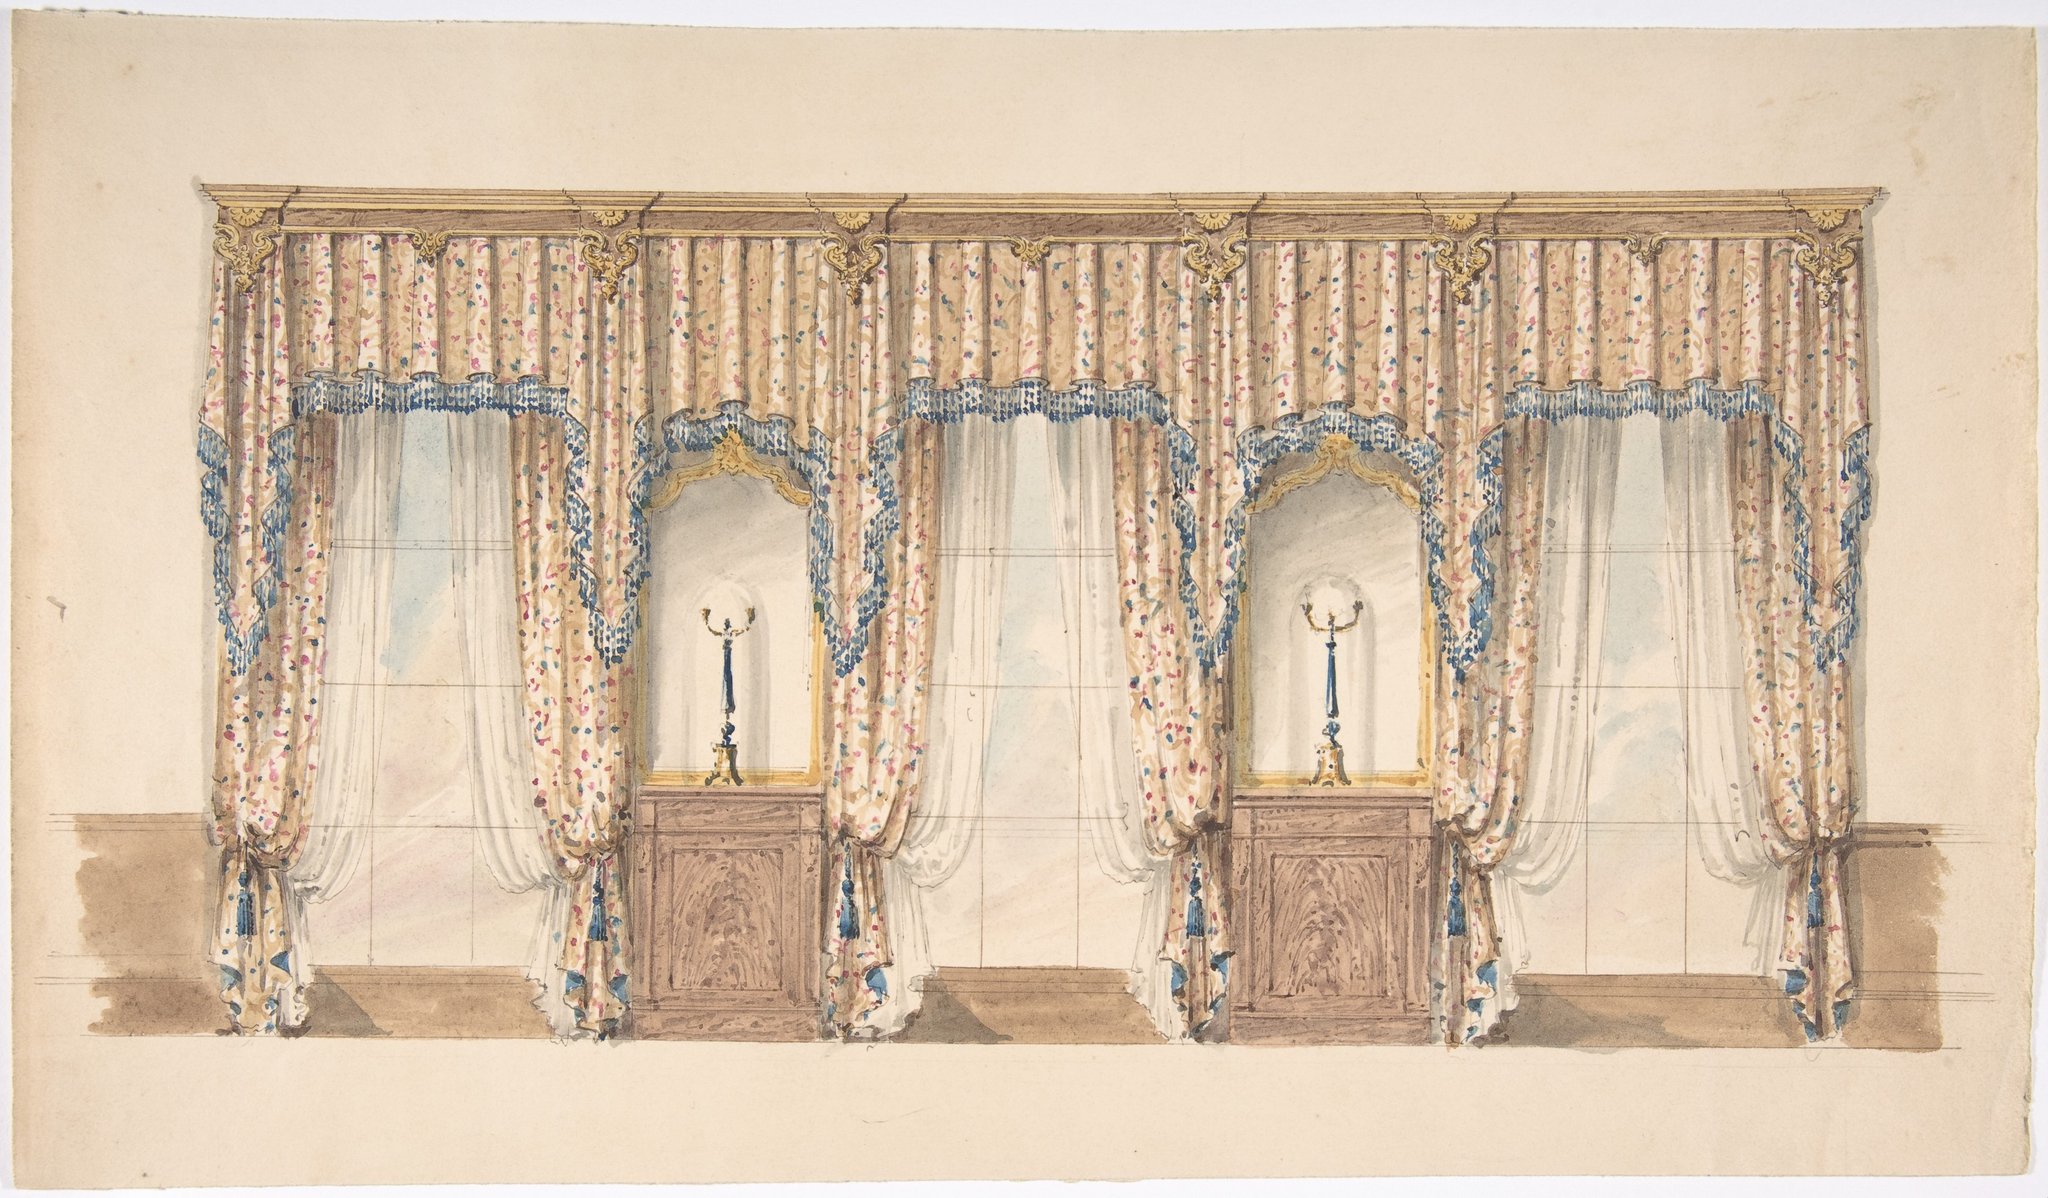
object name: drawing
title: Design for Pink, Gold, Blue and White Curtains with Blue Fringes and a Gold and Wood Pediment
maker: anonymous, british, 19th century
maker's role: artist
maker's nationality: british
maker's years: 1800-1900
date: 1801-1833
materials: ink, watercolor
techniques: brush, pen, wash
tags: curtains